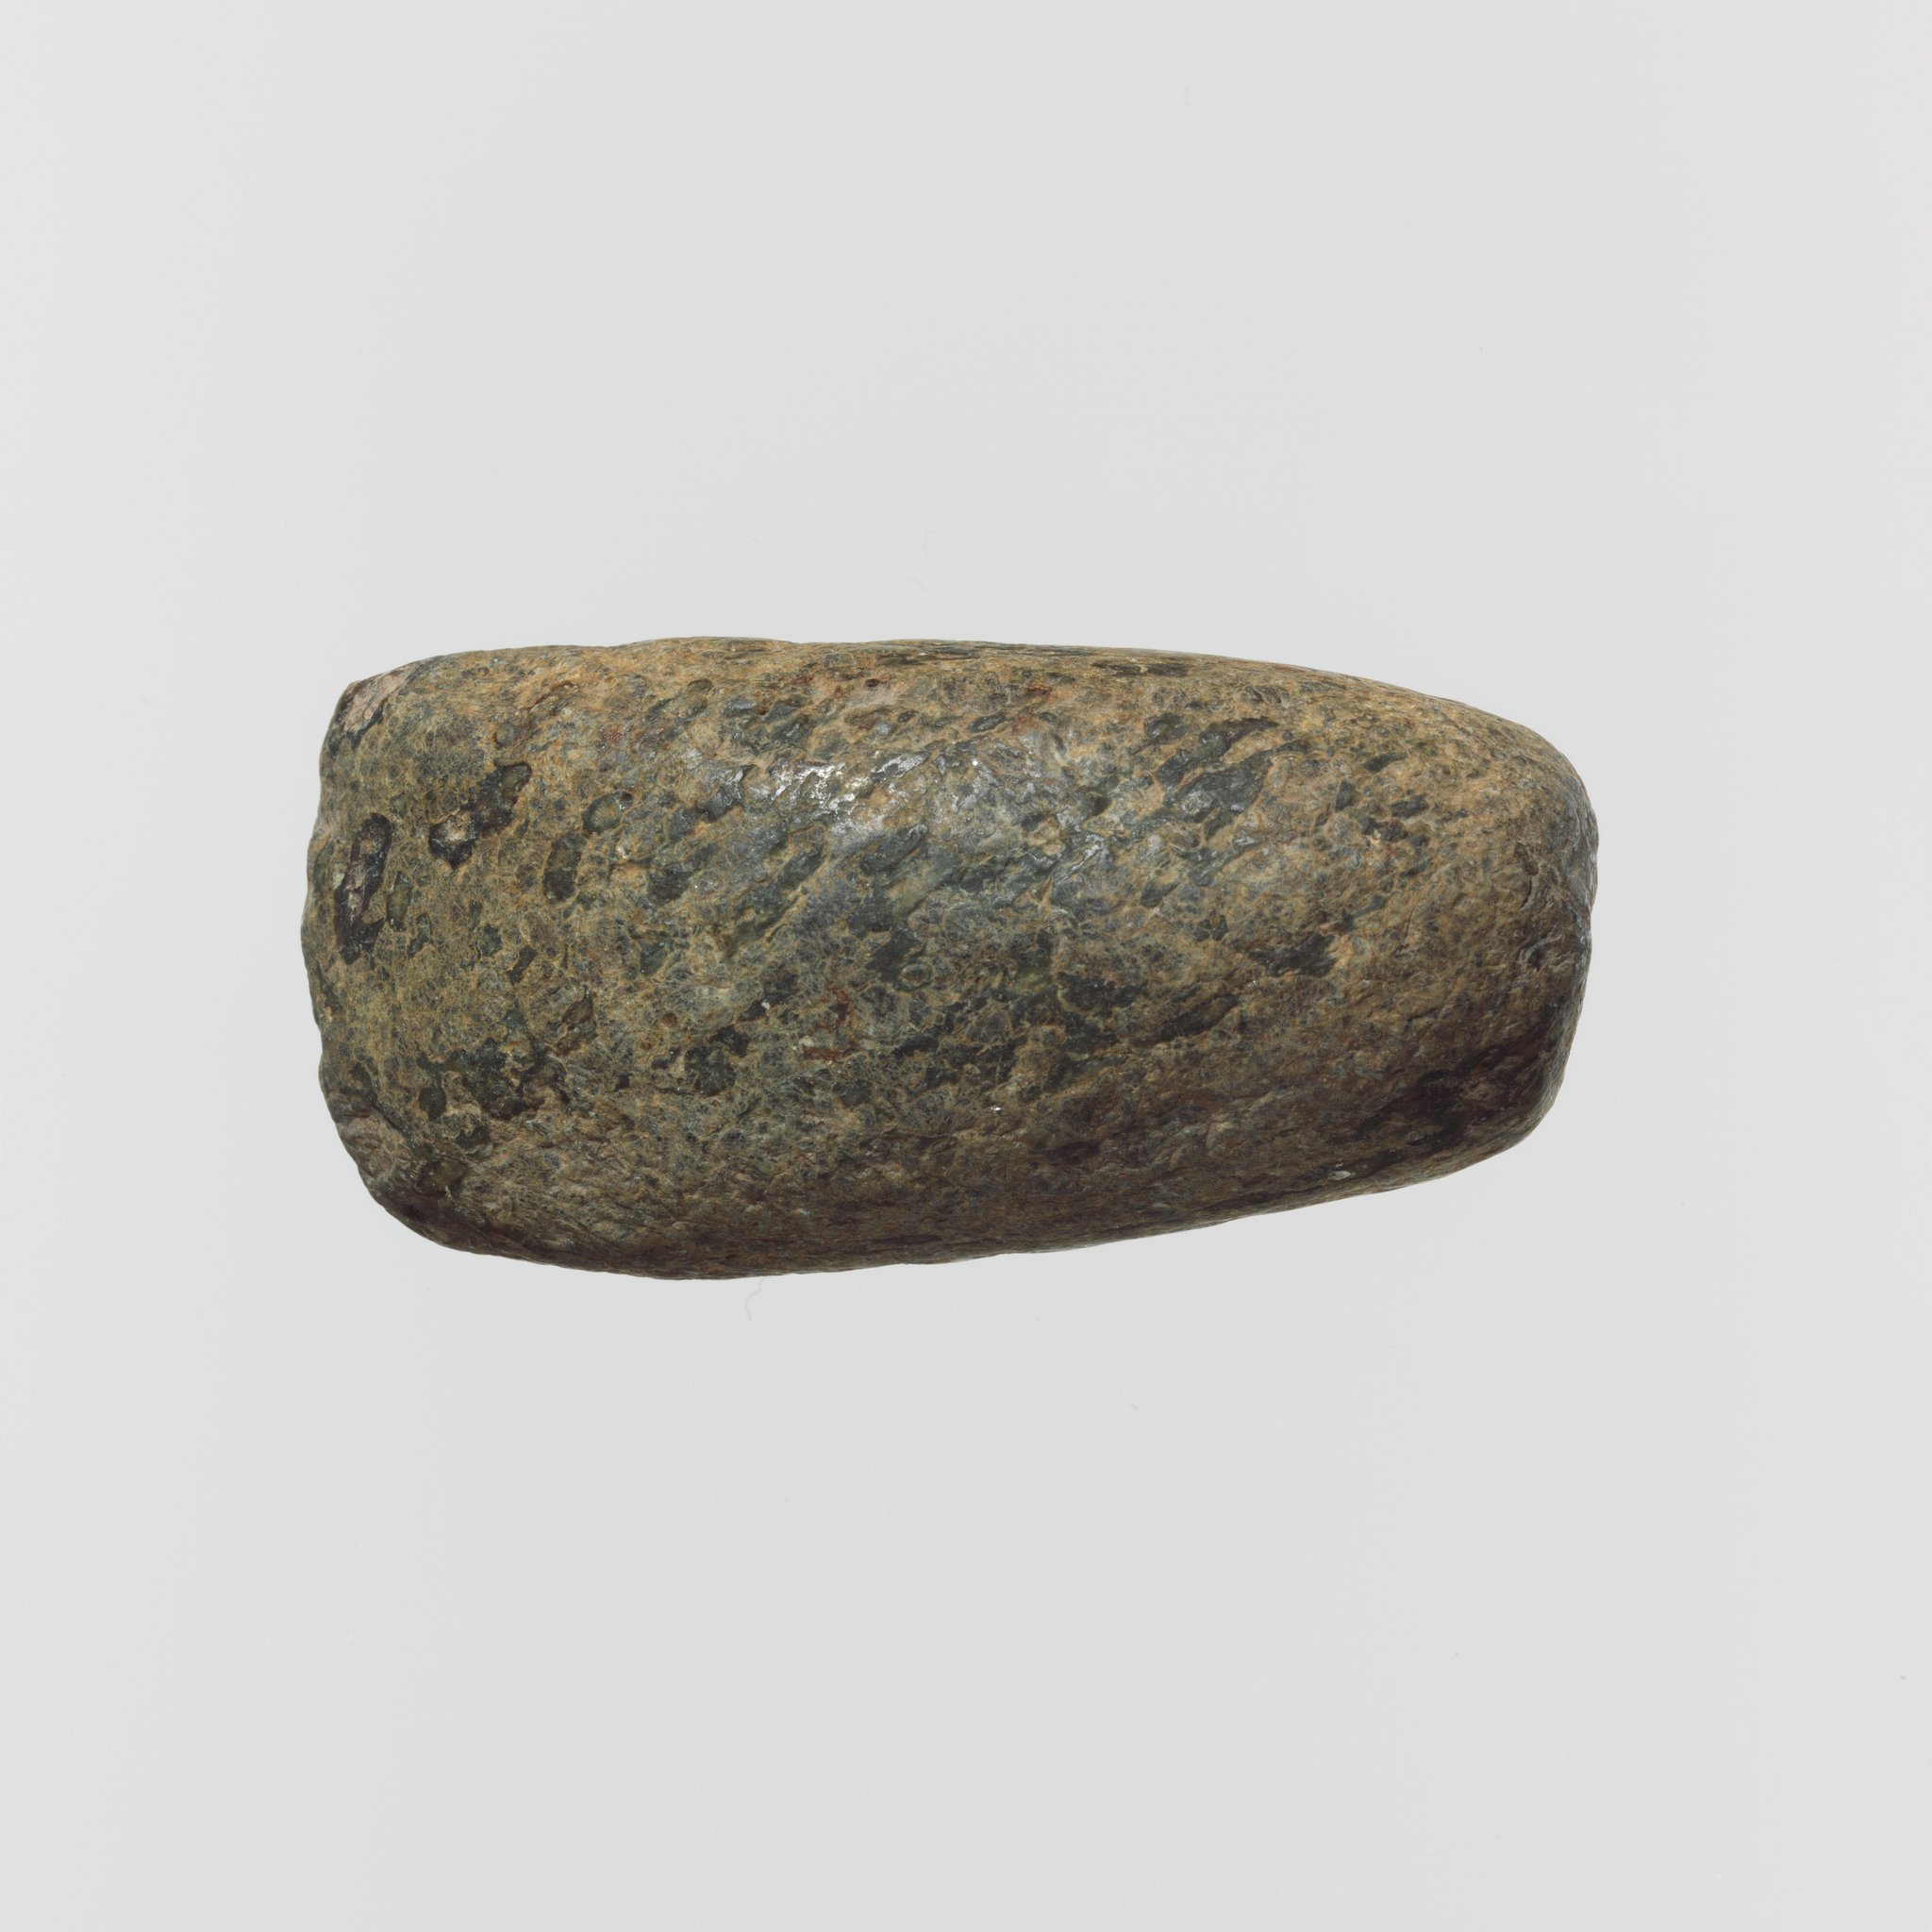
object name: celt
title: Small stone axe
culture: greek neolithic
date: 5000-2001 BCE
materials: stone